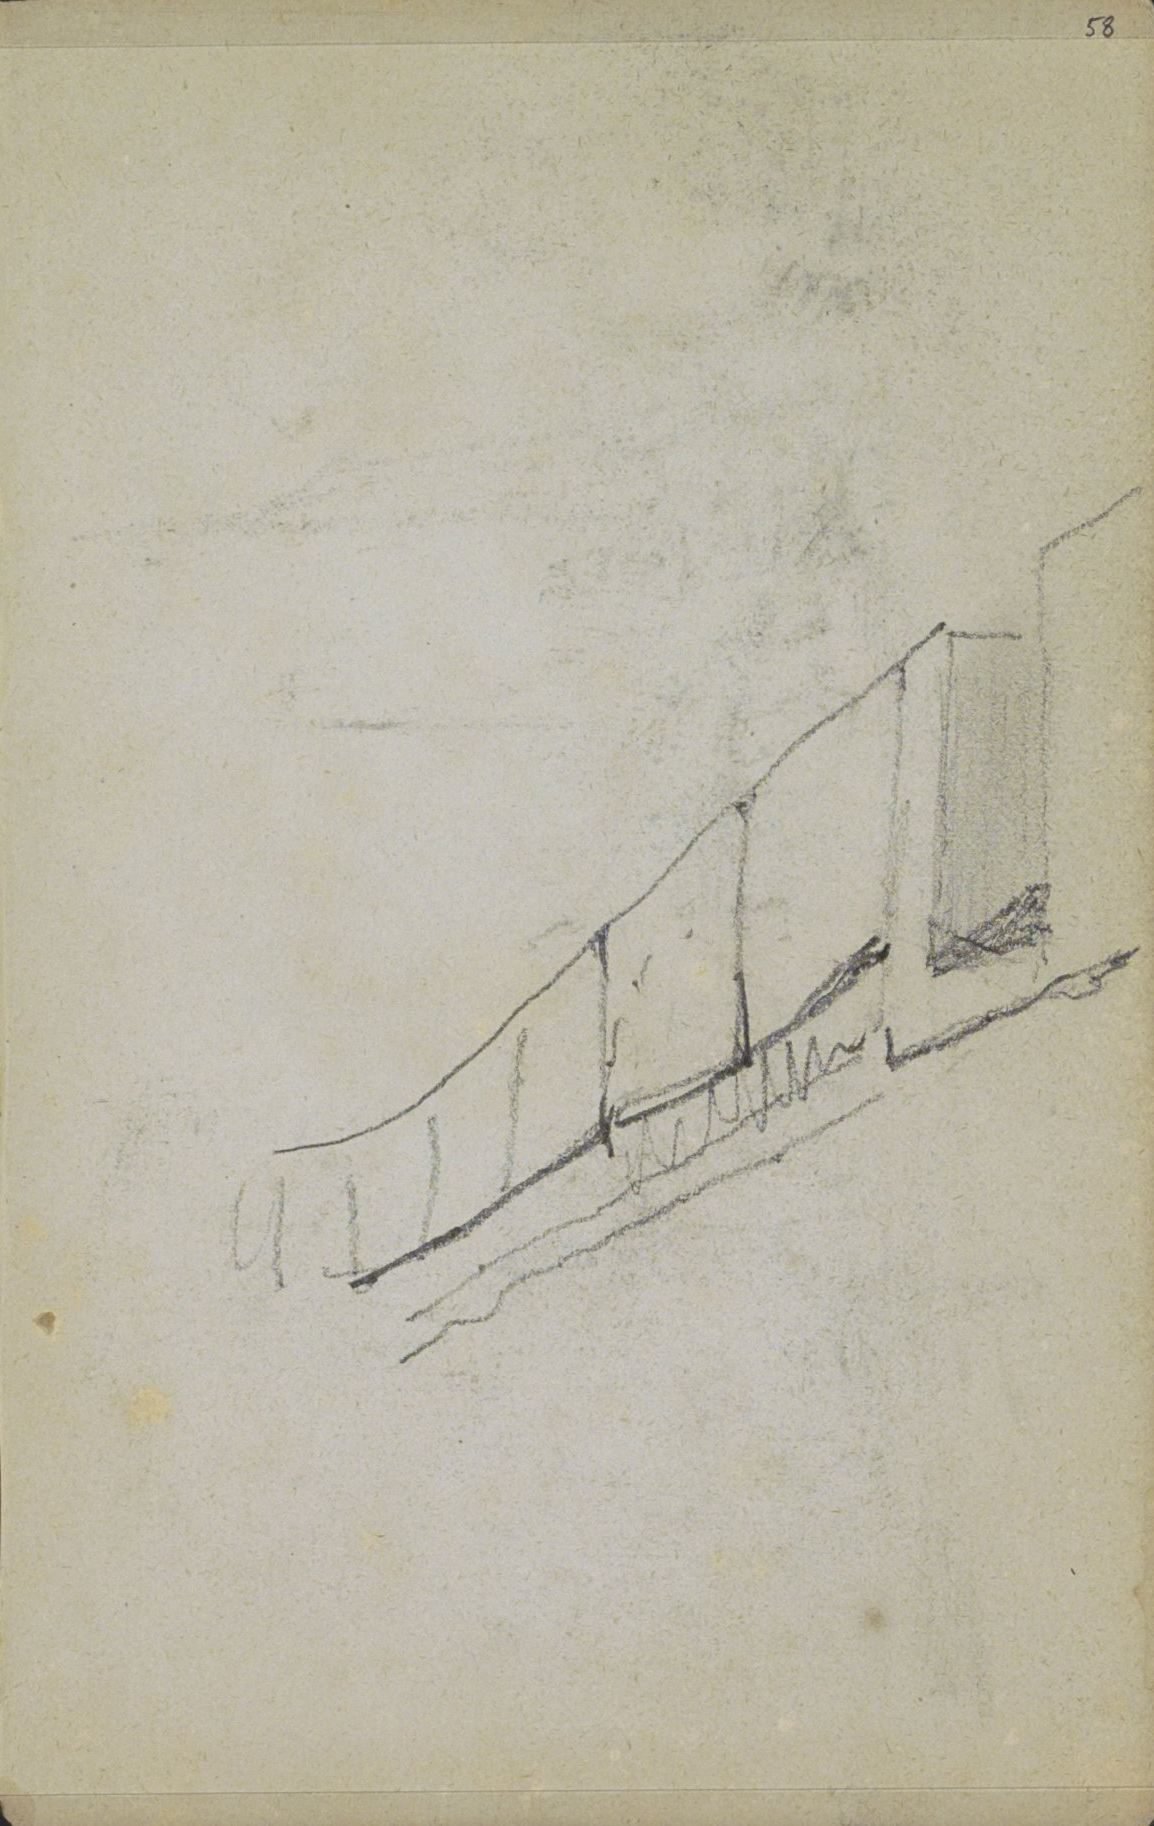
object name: sketchbook leaf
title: Studie, mogelijk van een muur met een poort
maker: adrianus eversen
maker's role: draughtsman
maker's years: 1818-1897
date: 1828-1897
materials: paper, pencil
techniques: stumping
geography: netherlands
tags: fence, wall, paling, gate, entrance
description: Studie, mogelijk van een muur met een poort. Blad 58 recto uit een schetsboek met 58 bladen.